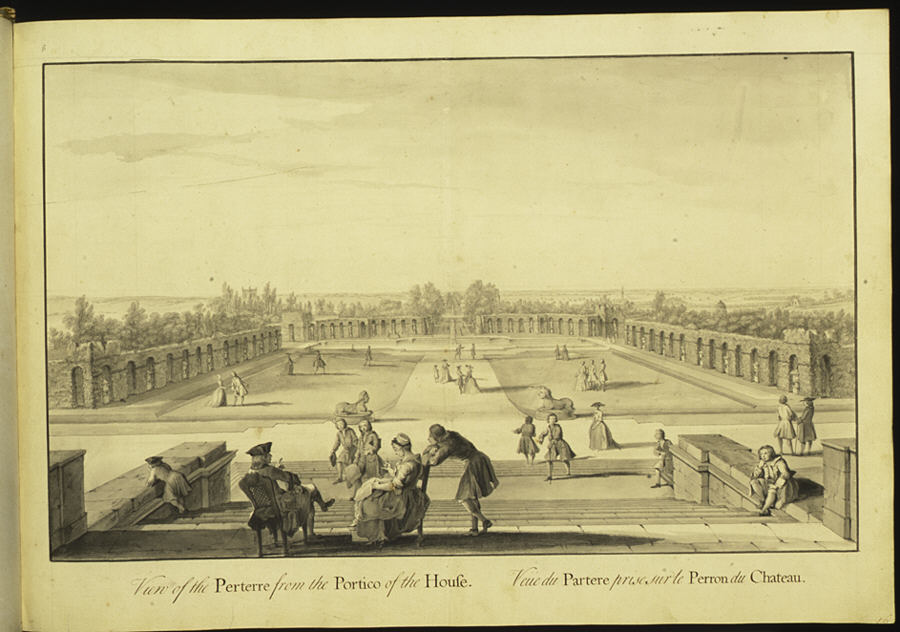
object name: drawing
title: View of the Parterre from the Portico of the House at Stowe, Buckinghamshire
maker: jacques rigaud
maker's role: artist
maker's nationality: french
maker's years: 1681-1754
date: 1733-1734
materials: ink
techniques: brush, pen, wash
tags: gardens,men,women